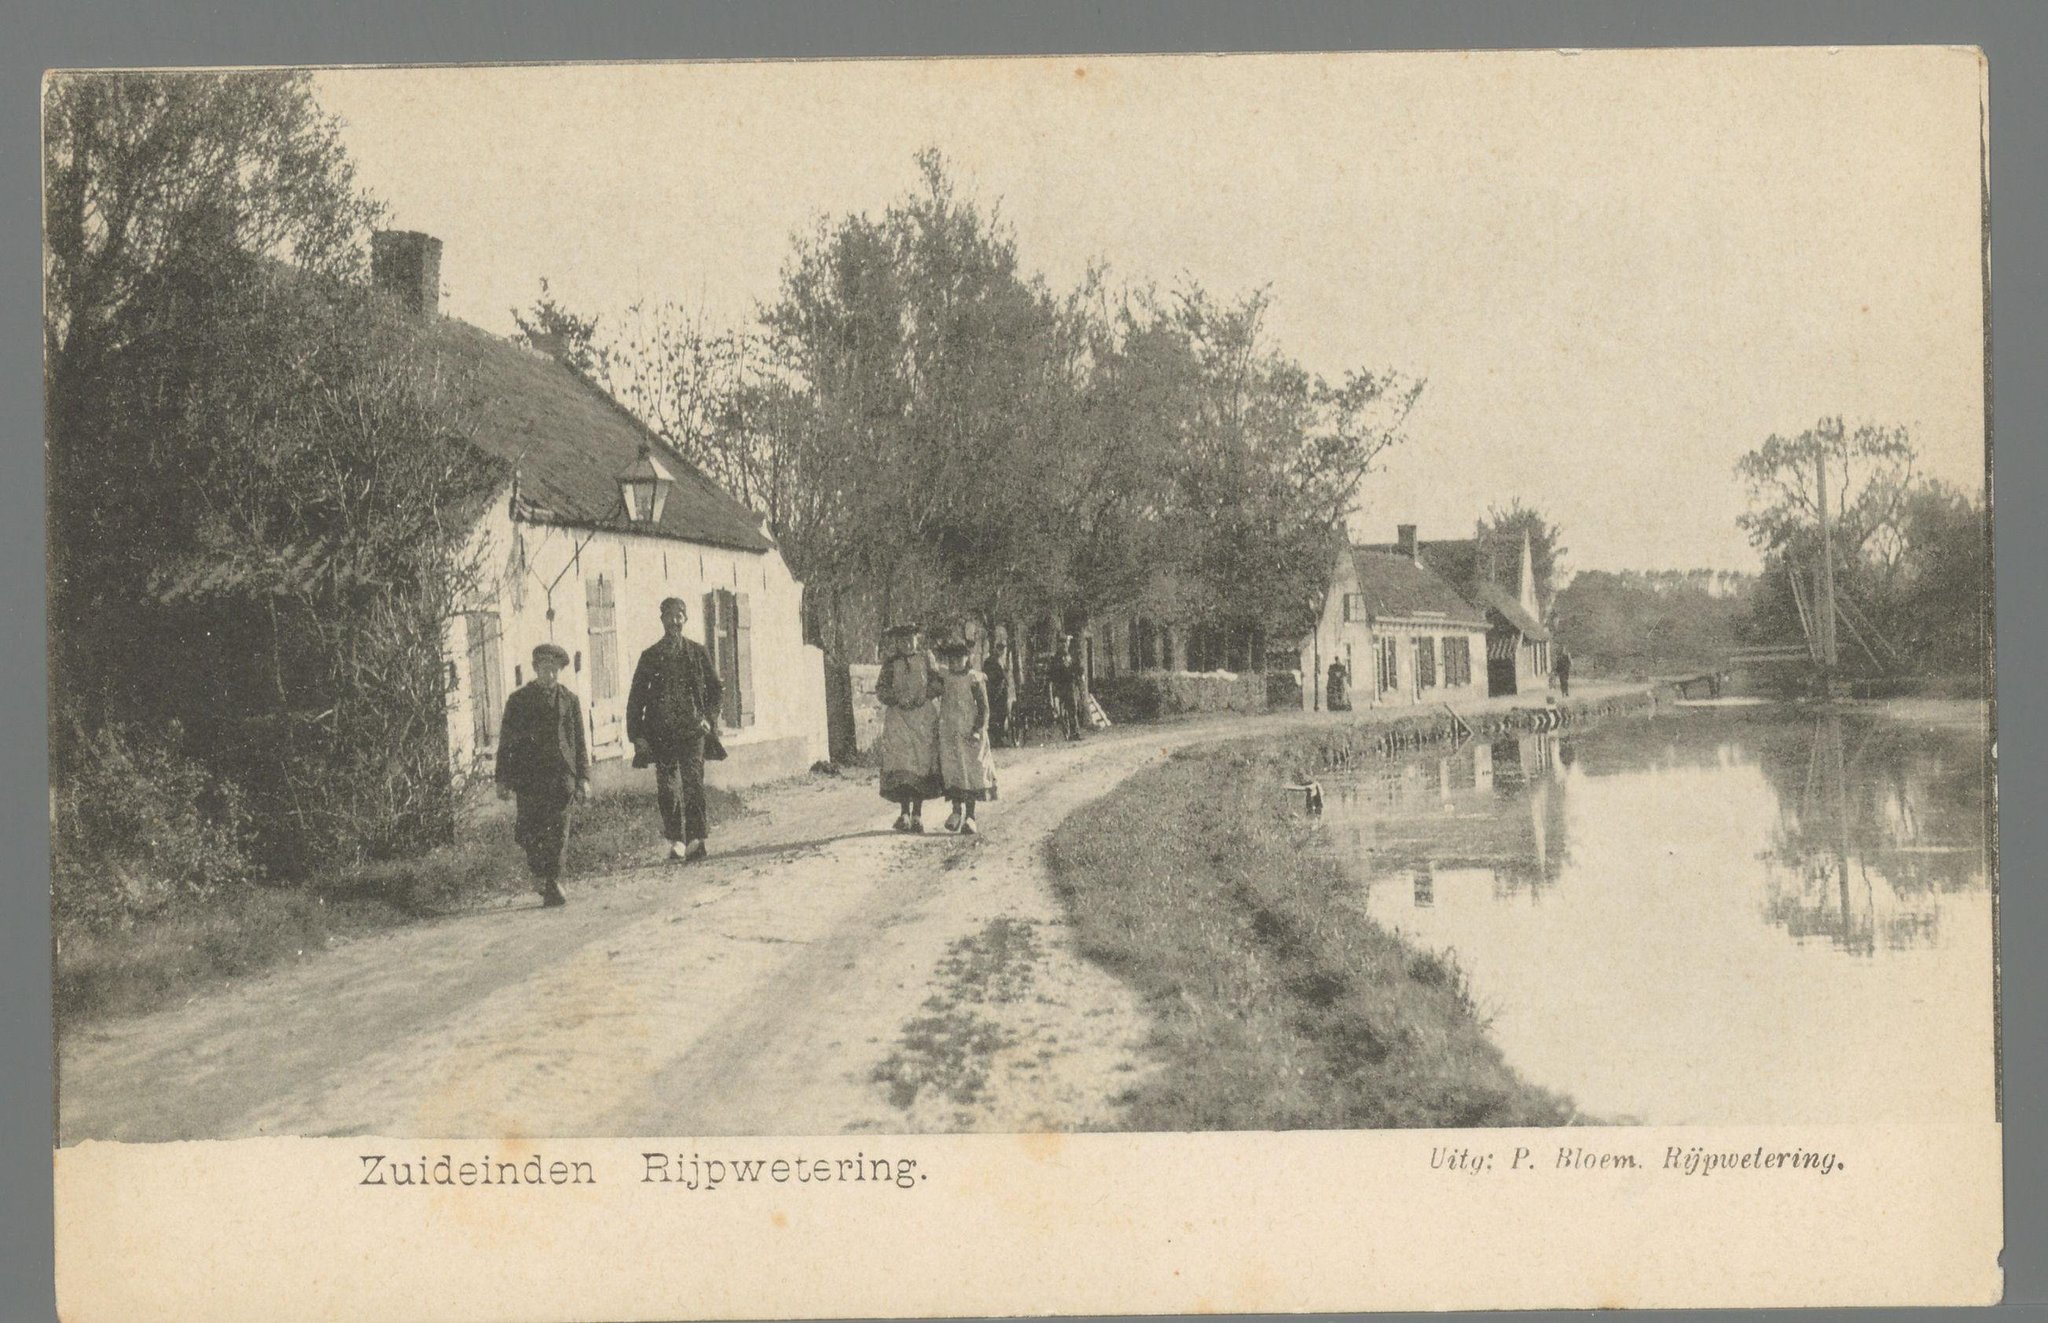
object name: photomechanical print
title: Zuideinden Rijpwetering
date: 1897-1905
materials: cardboard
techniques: photograph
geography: rijpwetering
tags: canals, waters (in village), street